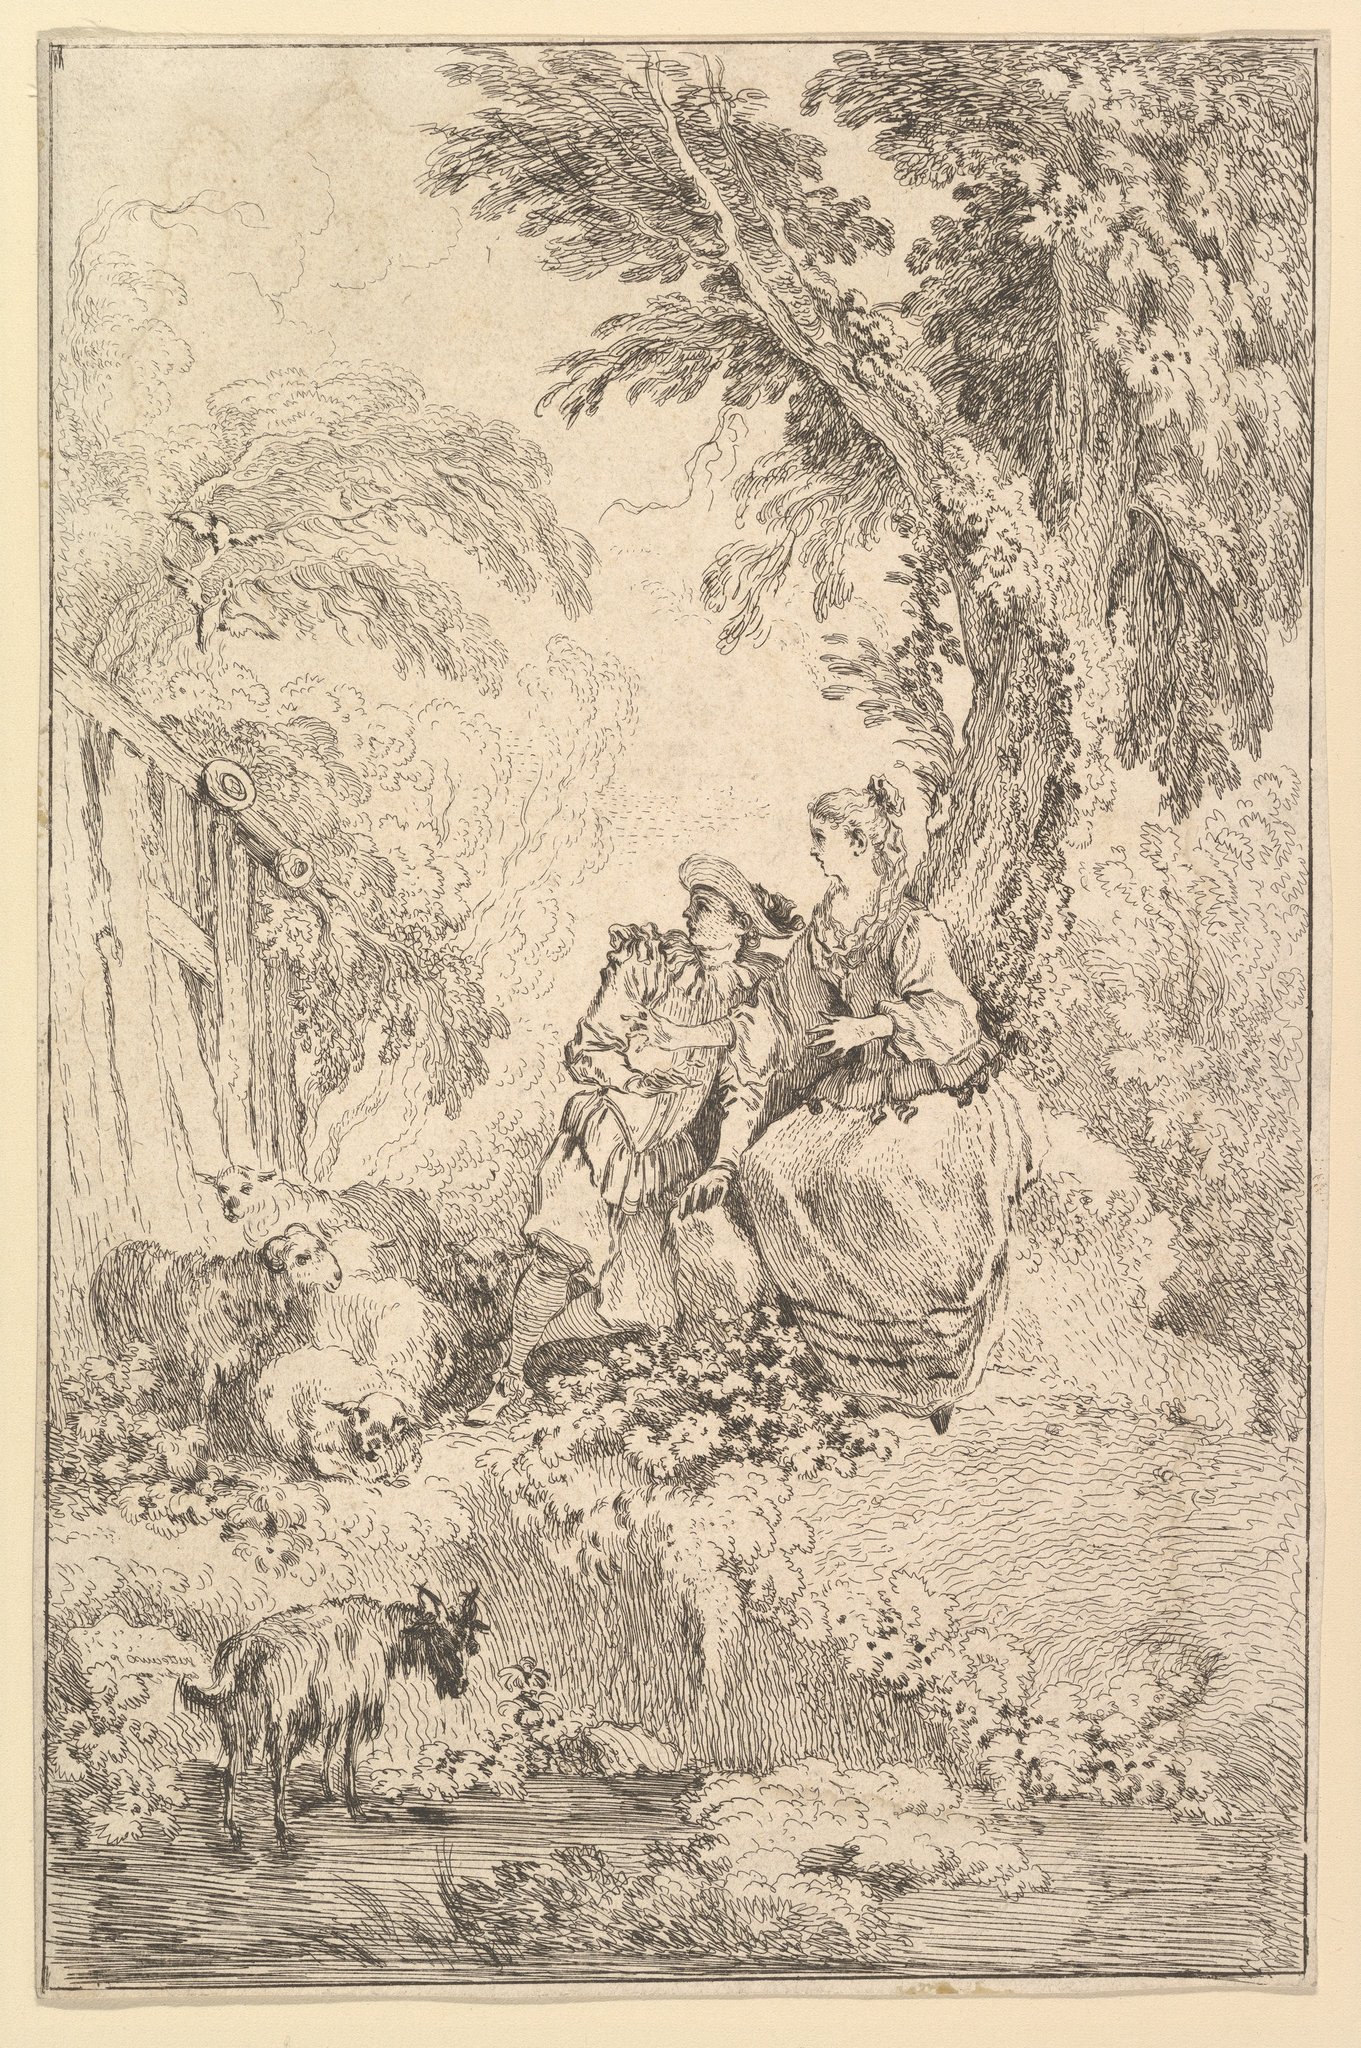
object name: print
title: Surprised Young Couple Under a Tree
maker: françois boucher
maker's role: artist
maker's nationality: french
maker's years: 1703-1770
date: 1730-1770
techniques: etching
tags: animals,couples,men,women,trees